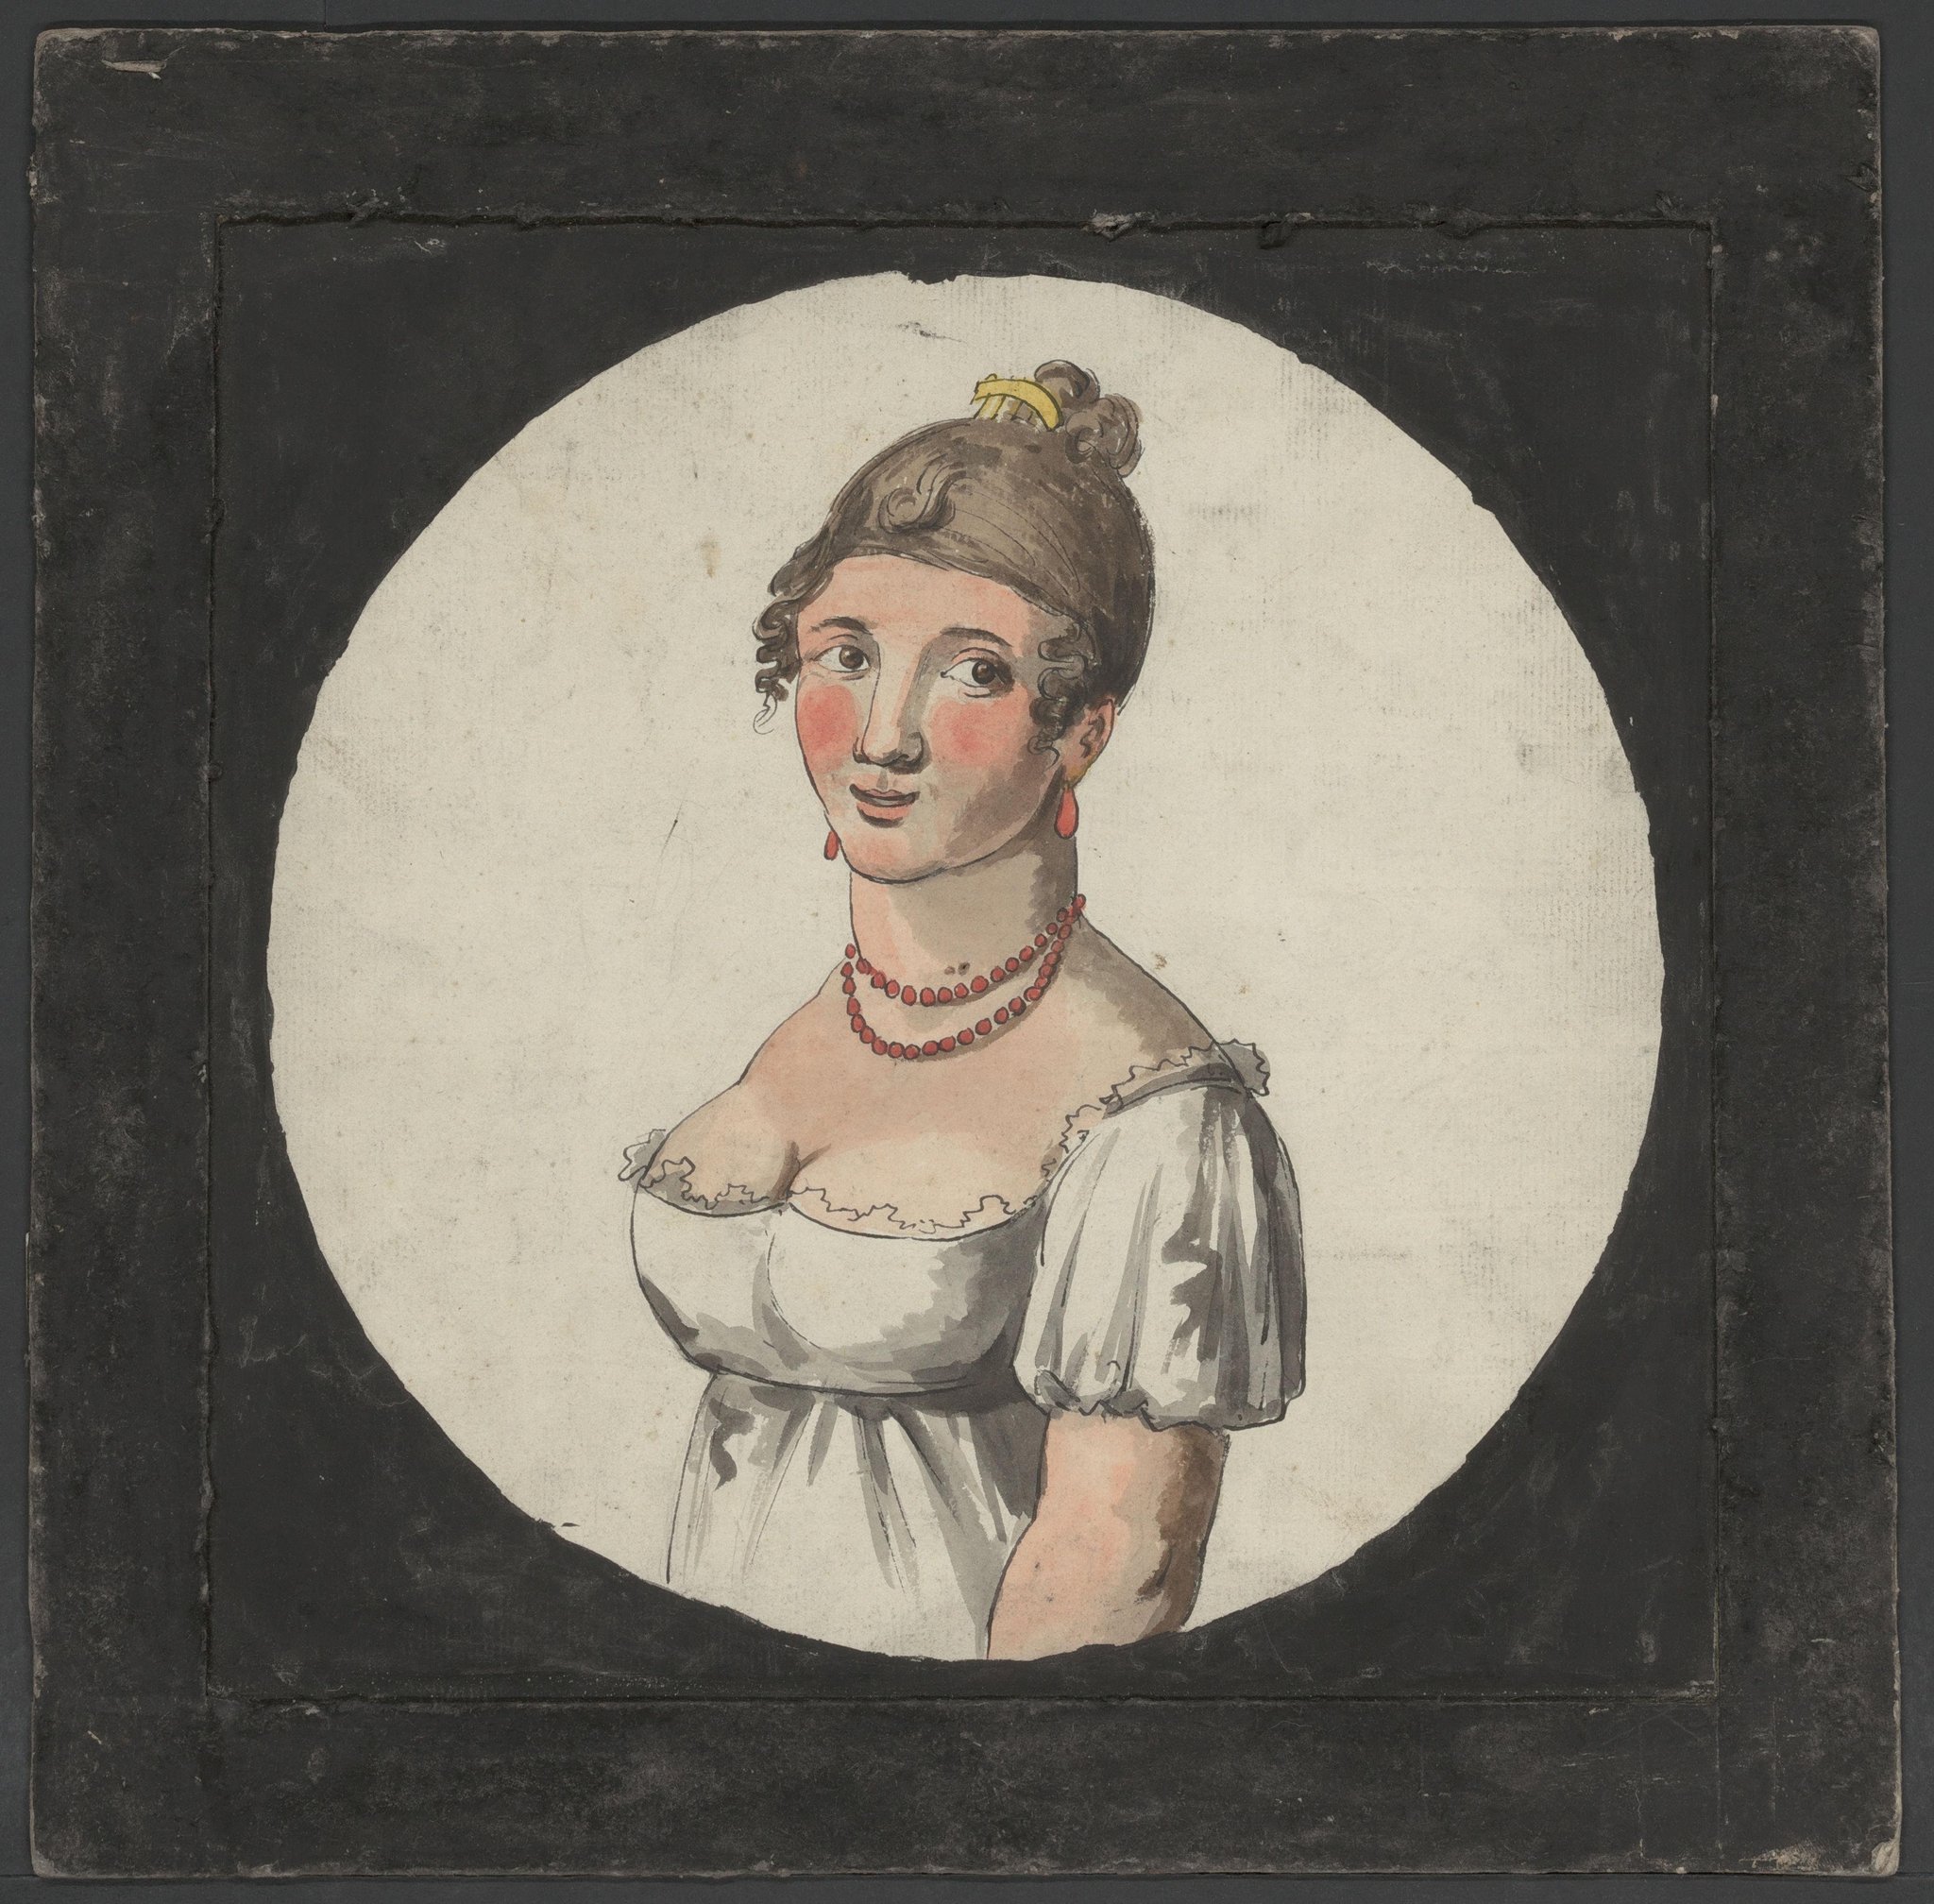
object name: drawing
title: Jonge vrouw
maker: jacob willemz. de vos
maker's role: draughtsman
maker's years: 1774-1844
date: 1800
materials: cardboard, ink, paper, watercolor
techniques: brush, pen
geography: netherlands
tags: amsterdam, utrecht, adolescent, young woman, maiden, historical persons - bb - woman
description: Een jonge vrouw ten halve lijve in een witte empire jurk. Onderdeel van een serie van elf ronde tekeningen die mogelijk als toverlantaarnplaat zijn gemaakt.